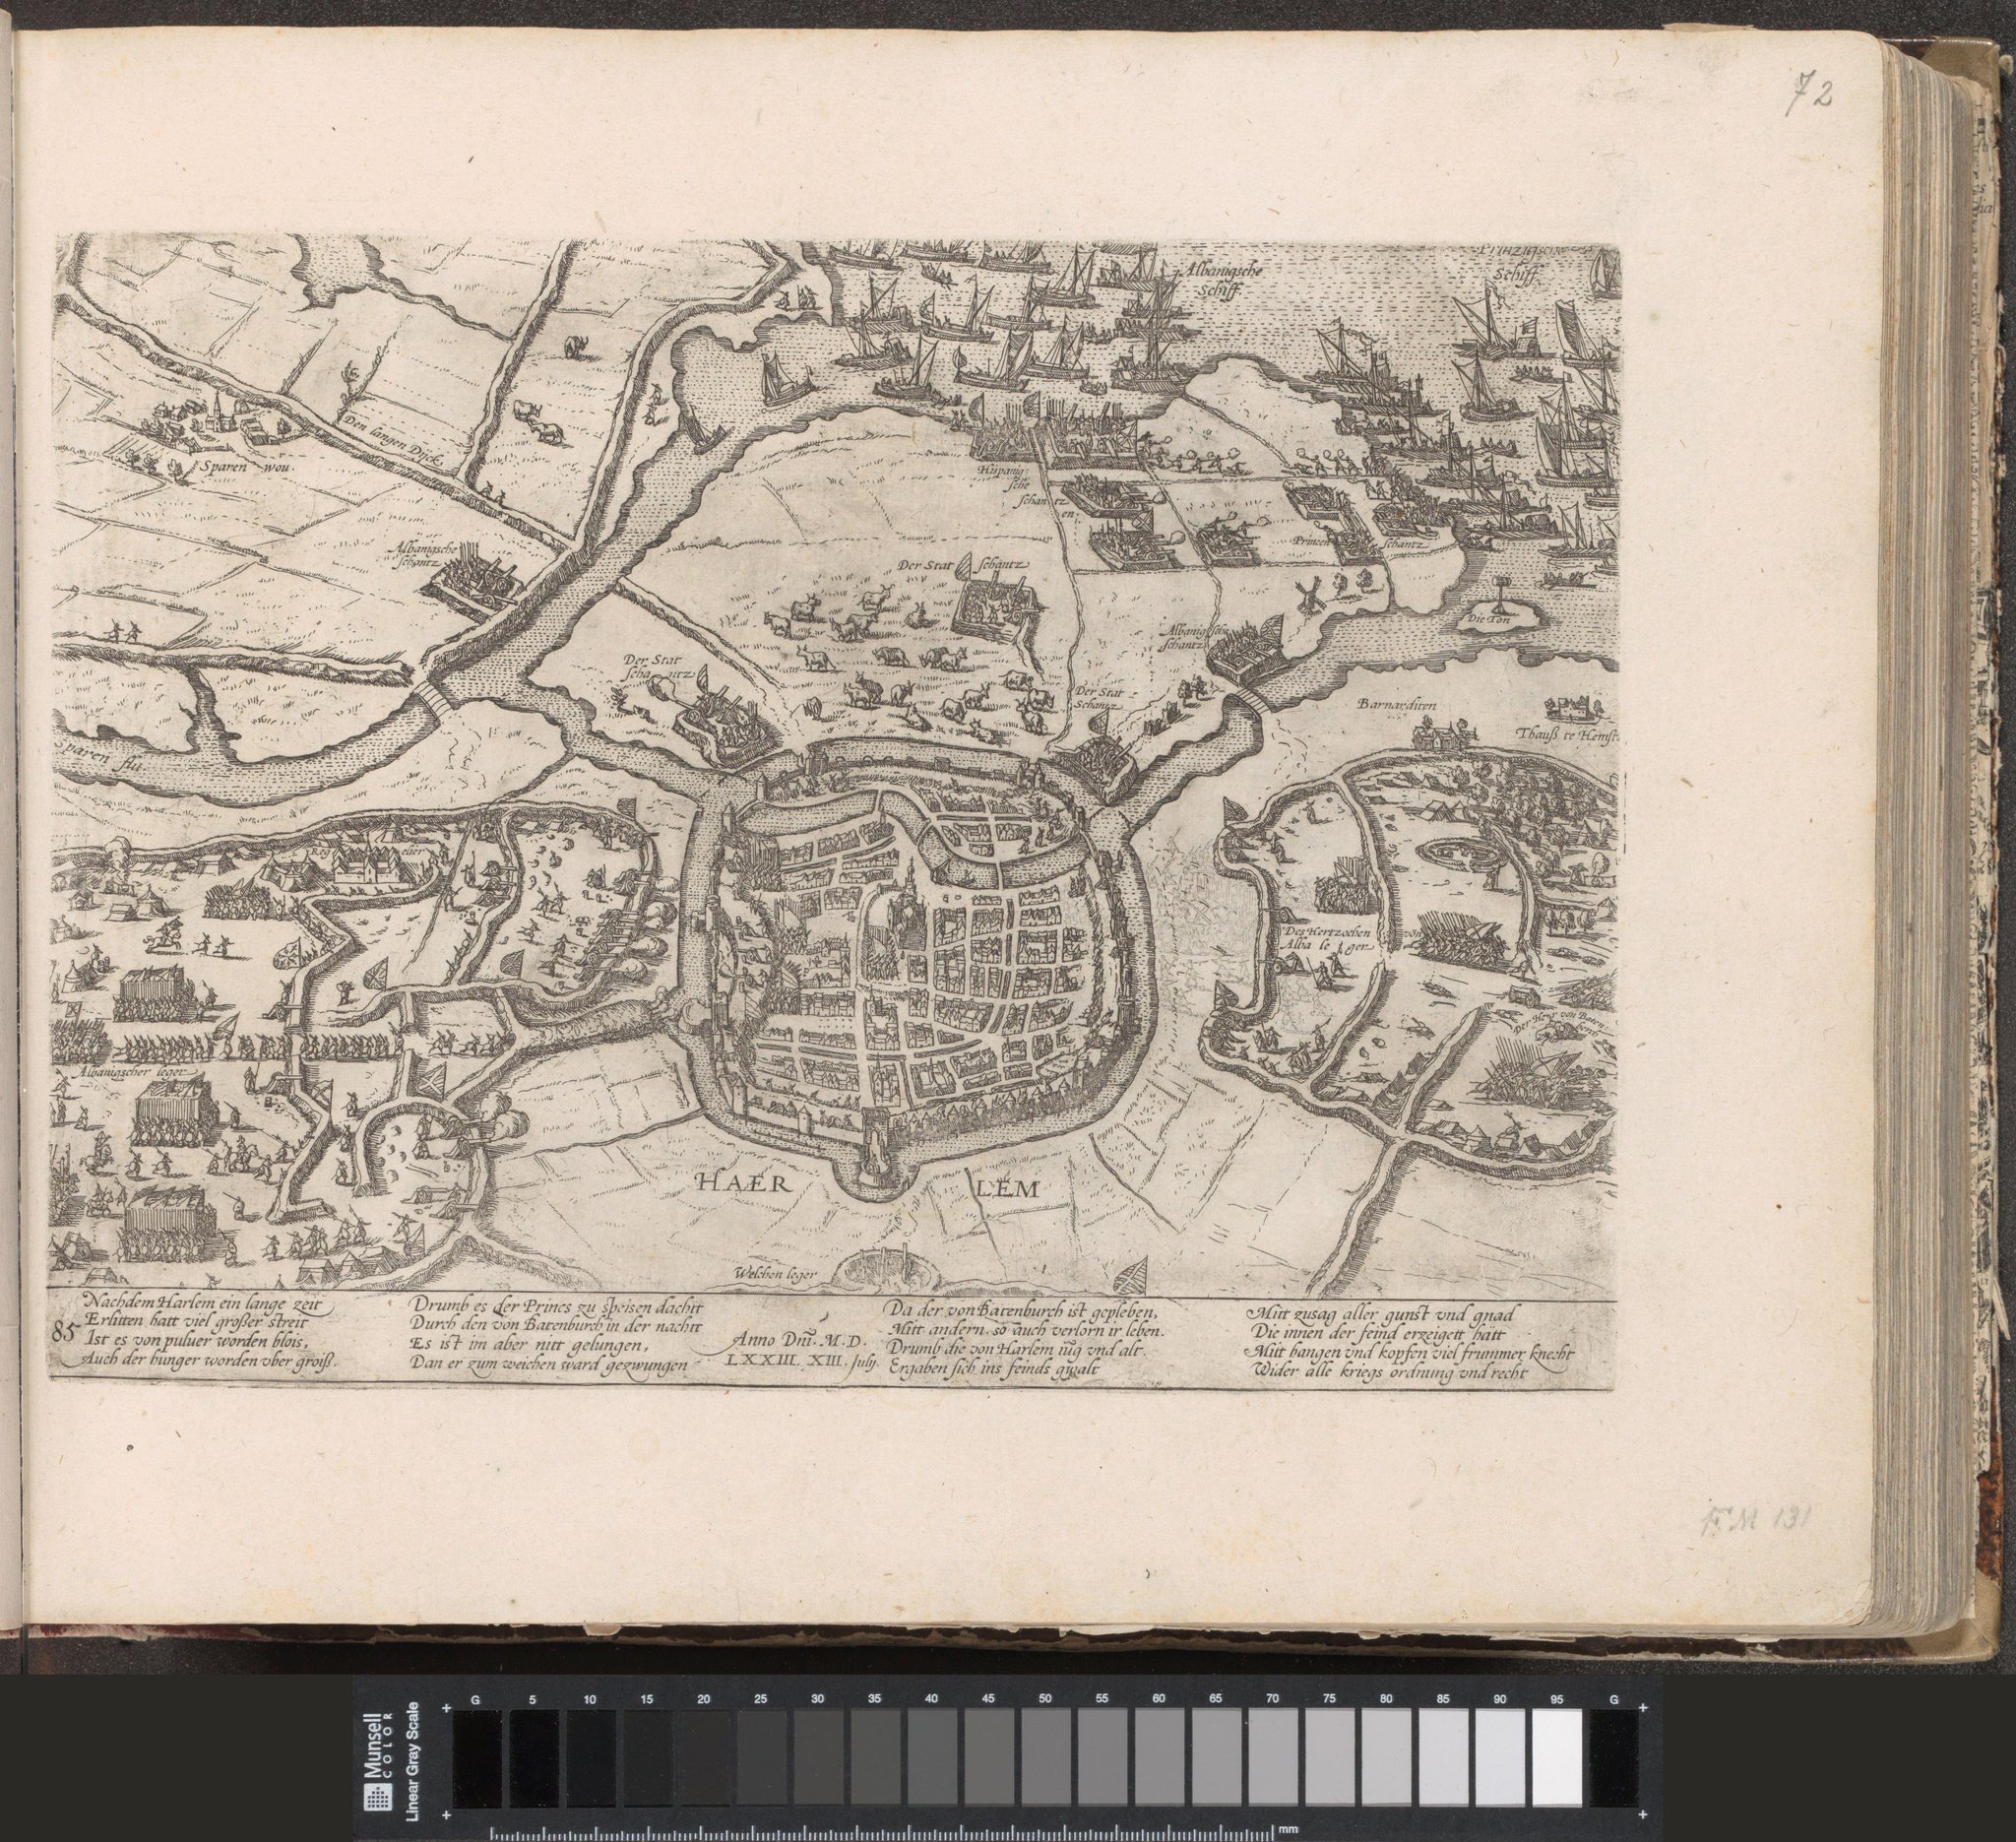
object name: album leaf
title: Serie 6: Nederlandse Gebeurtenissen, 1571-1576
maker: frans hogenberg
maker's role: print maker, publisher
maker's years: 1538-1590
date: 1574-1578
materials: paper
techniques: etching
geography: cologne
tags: siege, position war, haarlem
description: Kaart van de stad Haarlem en het omringend gebied met de legerplaatsen van de belegerende Spaanse troepen van Don Frederik. Boven schepen van Alva en de prins van Oranje op het water van het Haarlemmermeer. Het beleg ving aan op 11 december 1572. Met onderschrift van 16 regels in het Duits. Linksonder genummerd: 85. De prent maakt deel uit van een album.